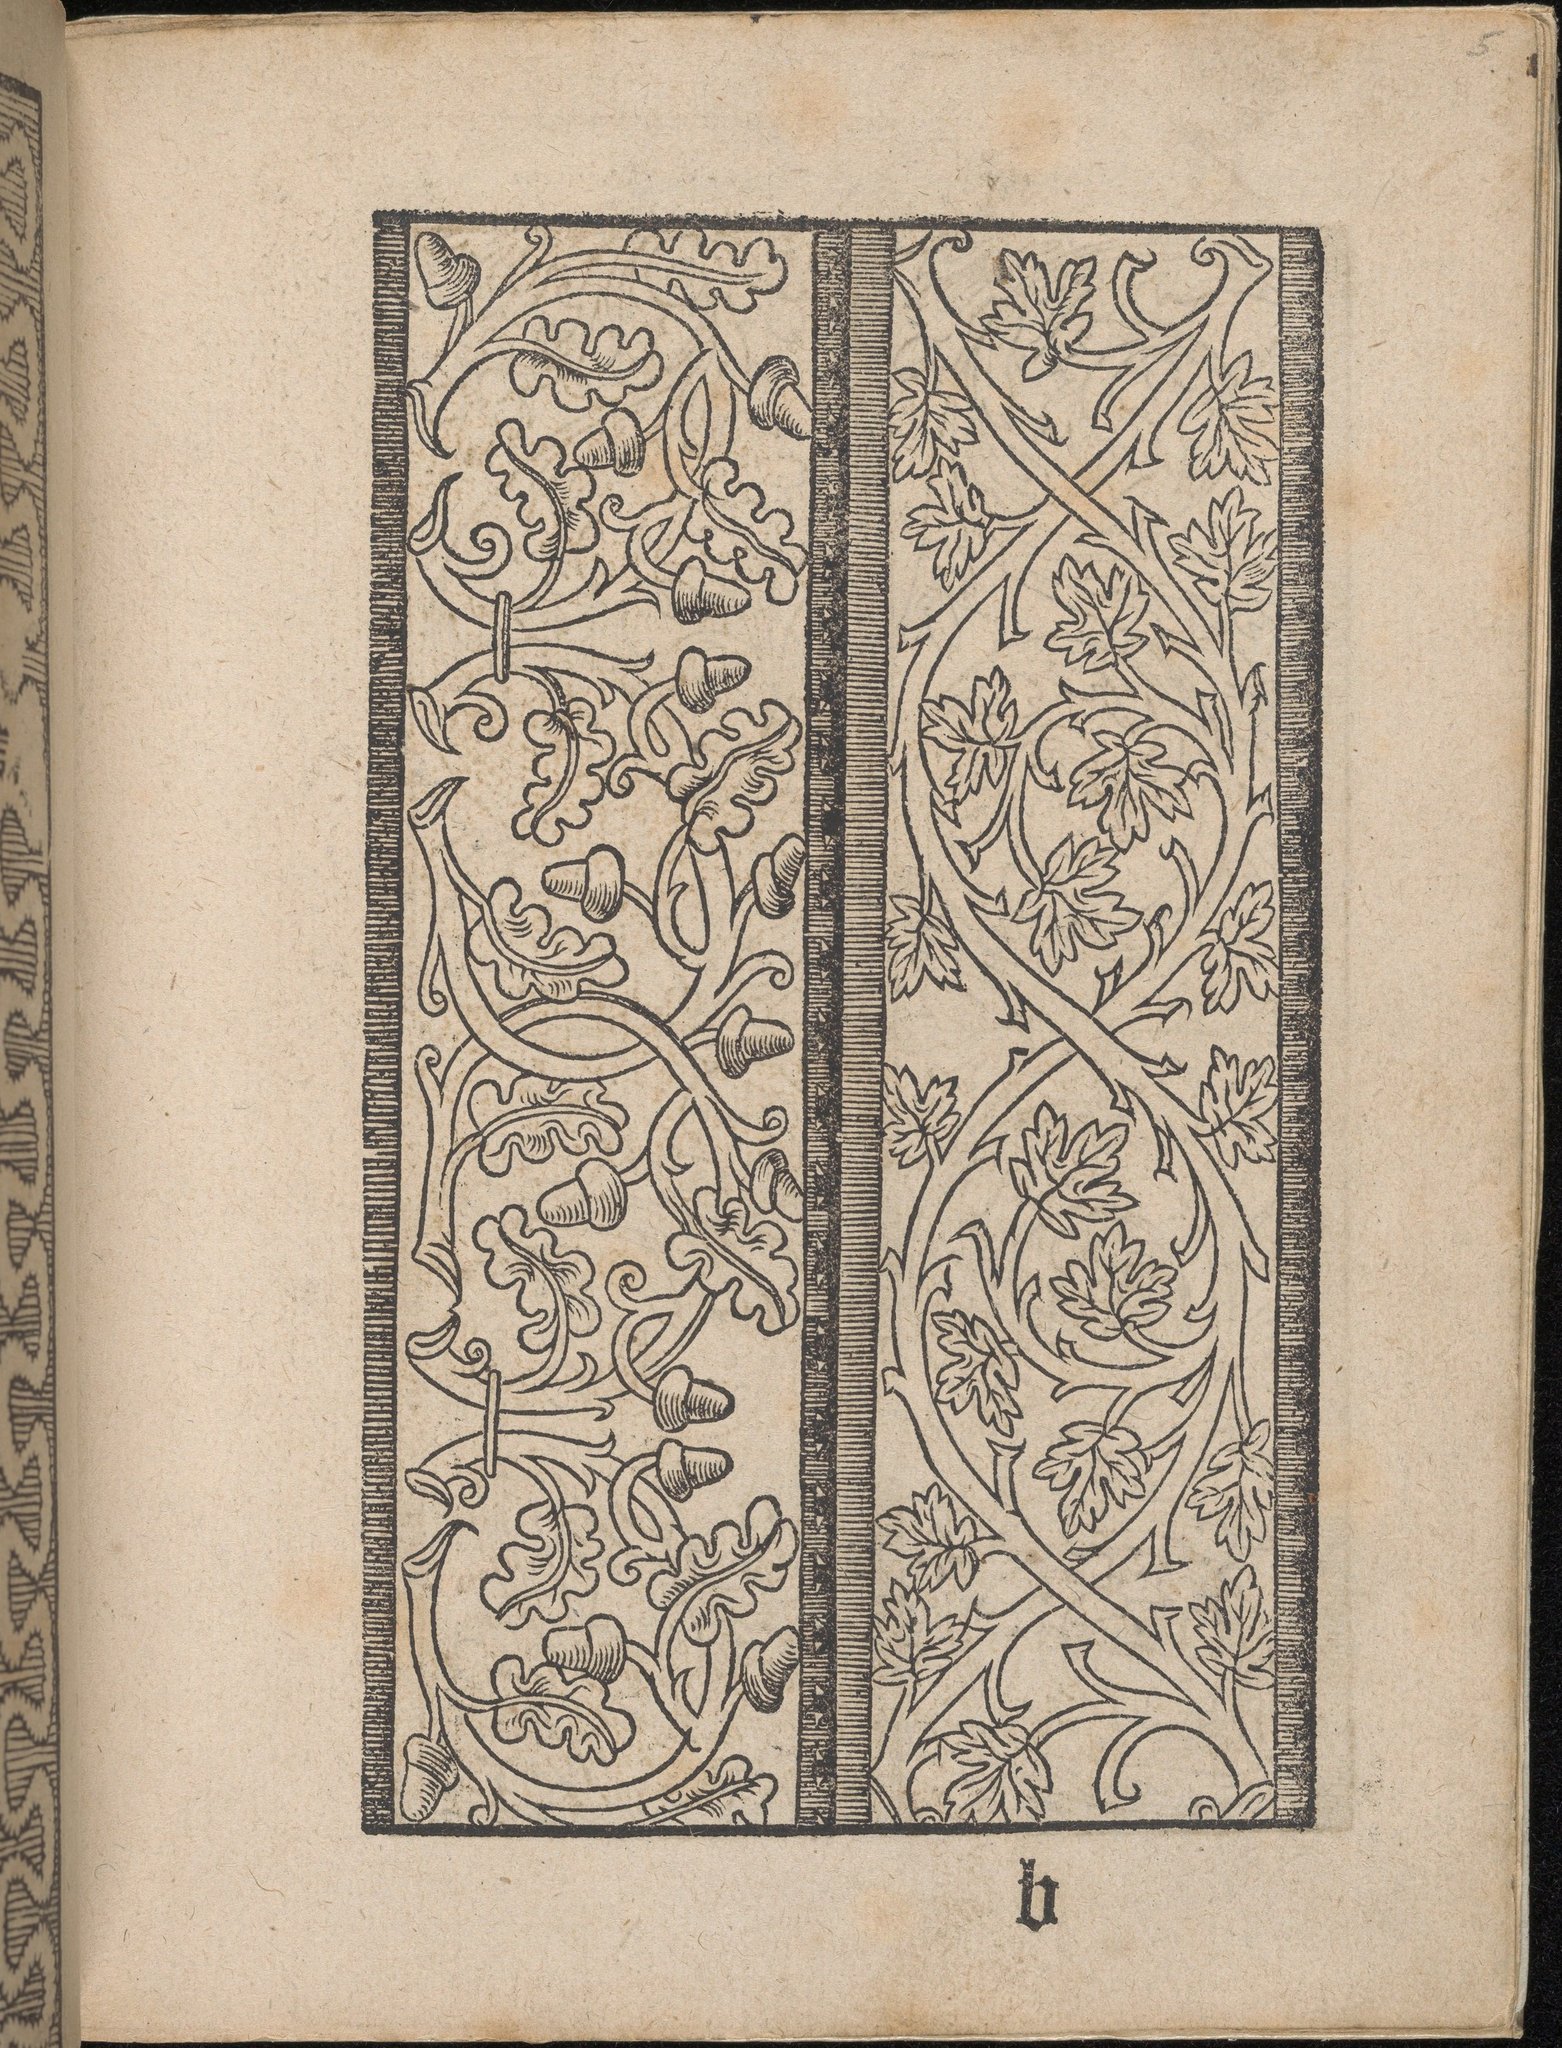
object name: book print ornament architecture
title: Ein new Modelbuch..., page 3 (recto)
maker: johann schönsperger the younger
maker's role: publisher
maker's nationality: german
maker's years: 1490-1550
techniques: woodcut